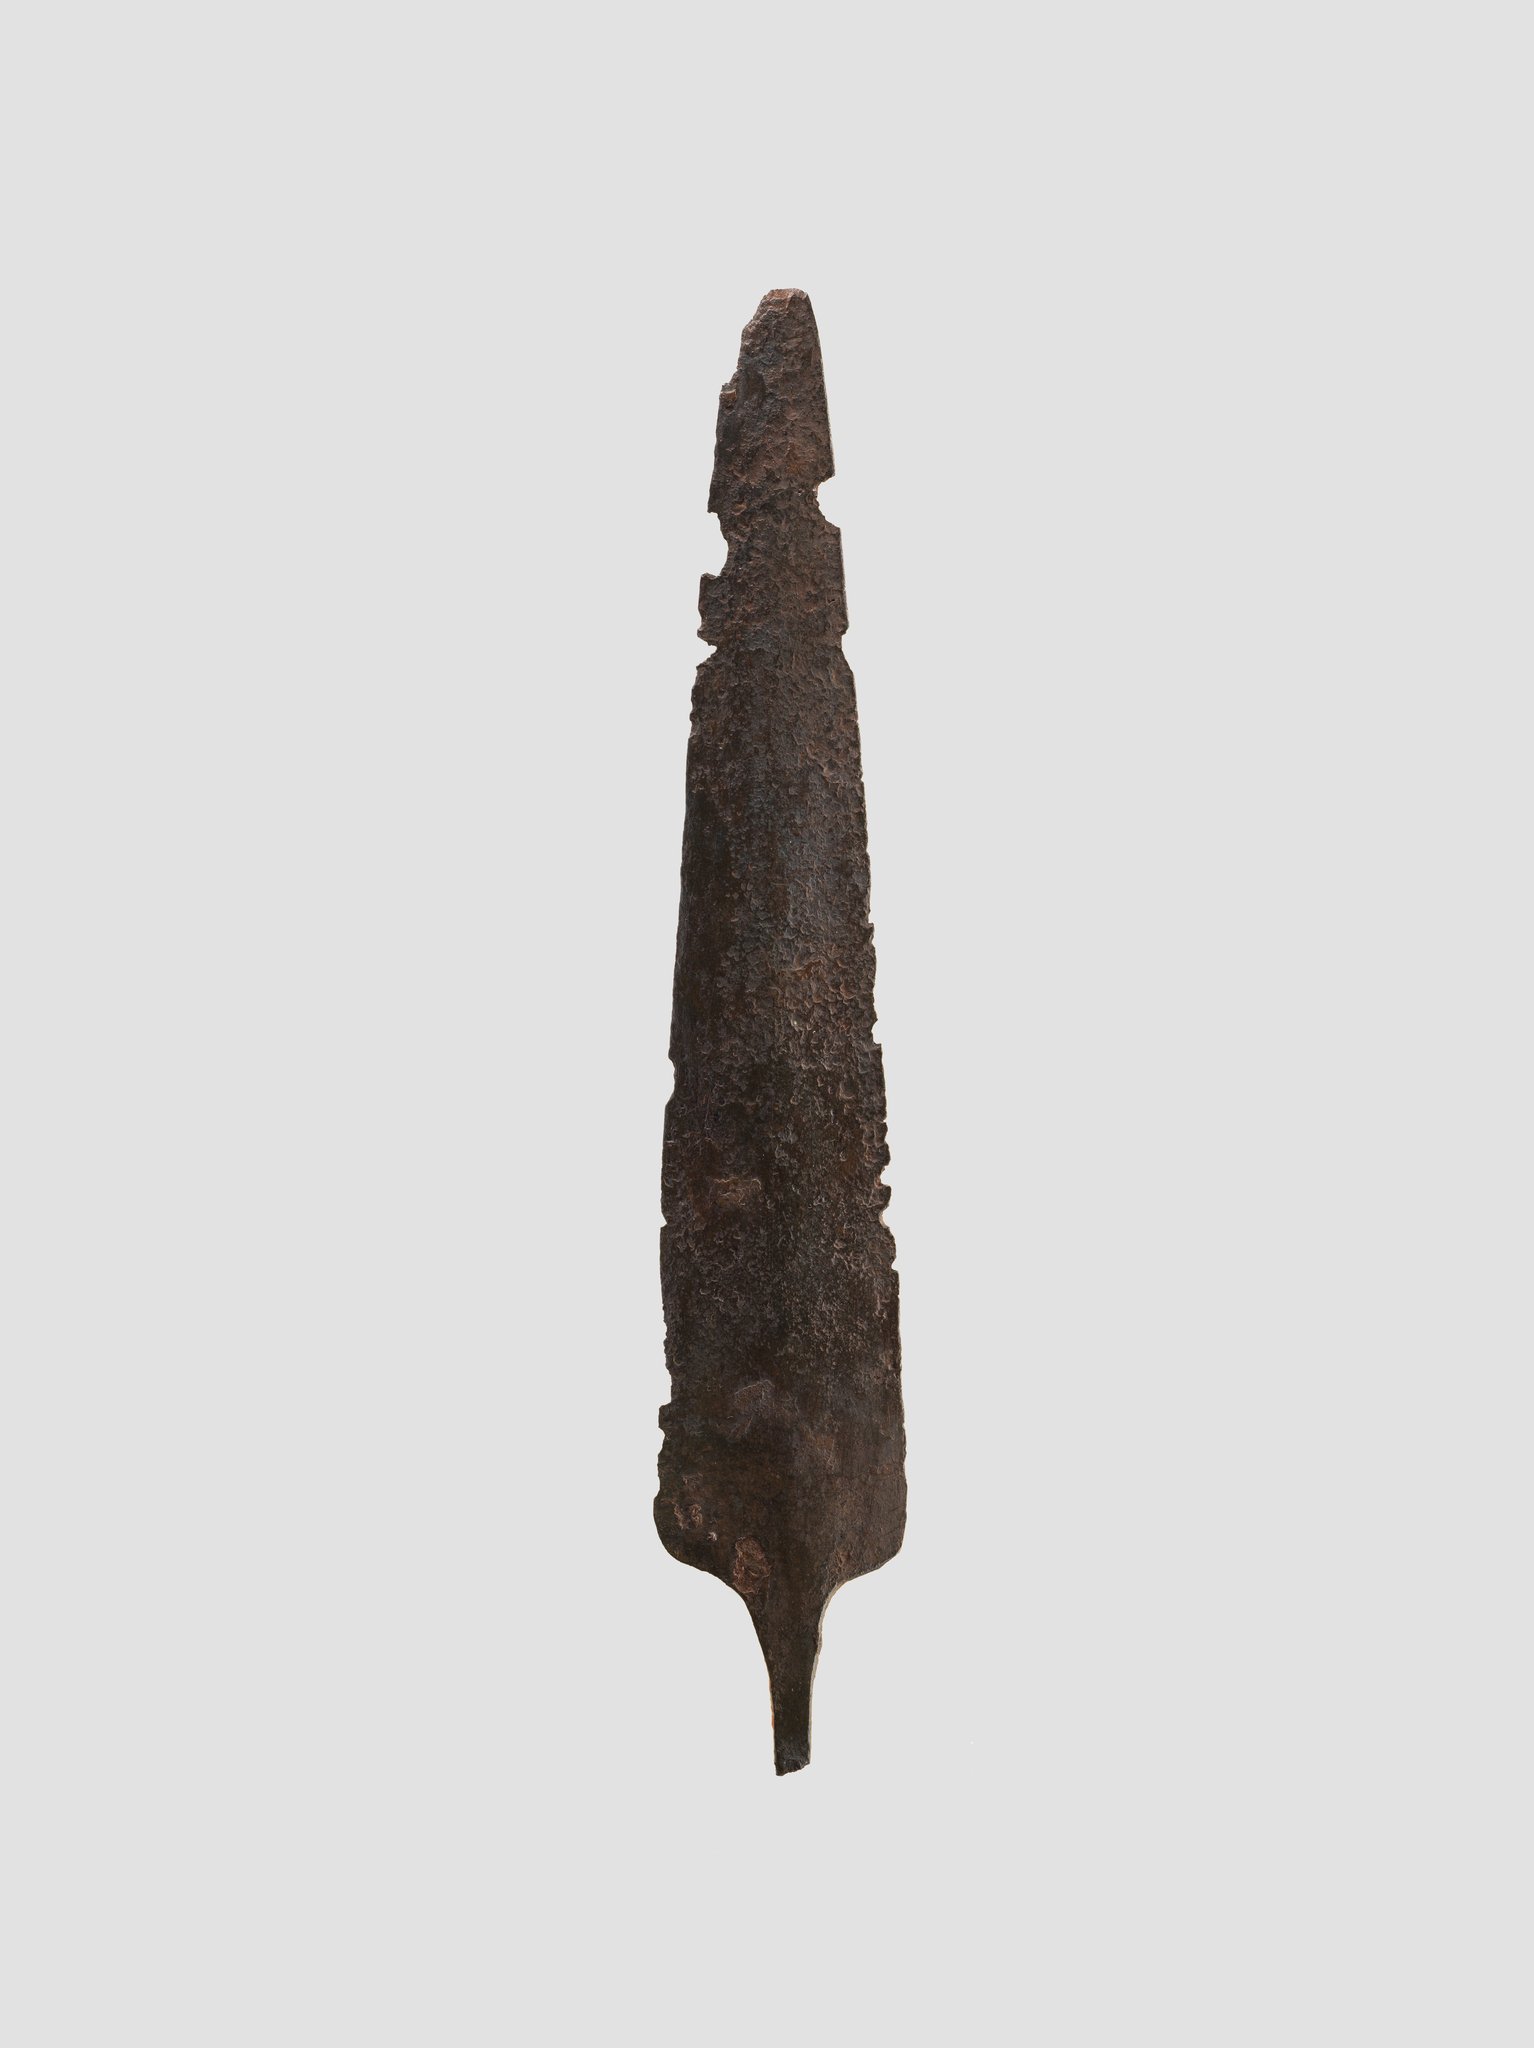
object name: spearhead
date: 1780-1580 BCE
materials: bronze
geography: levant